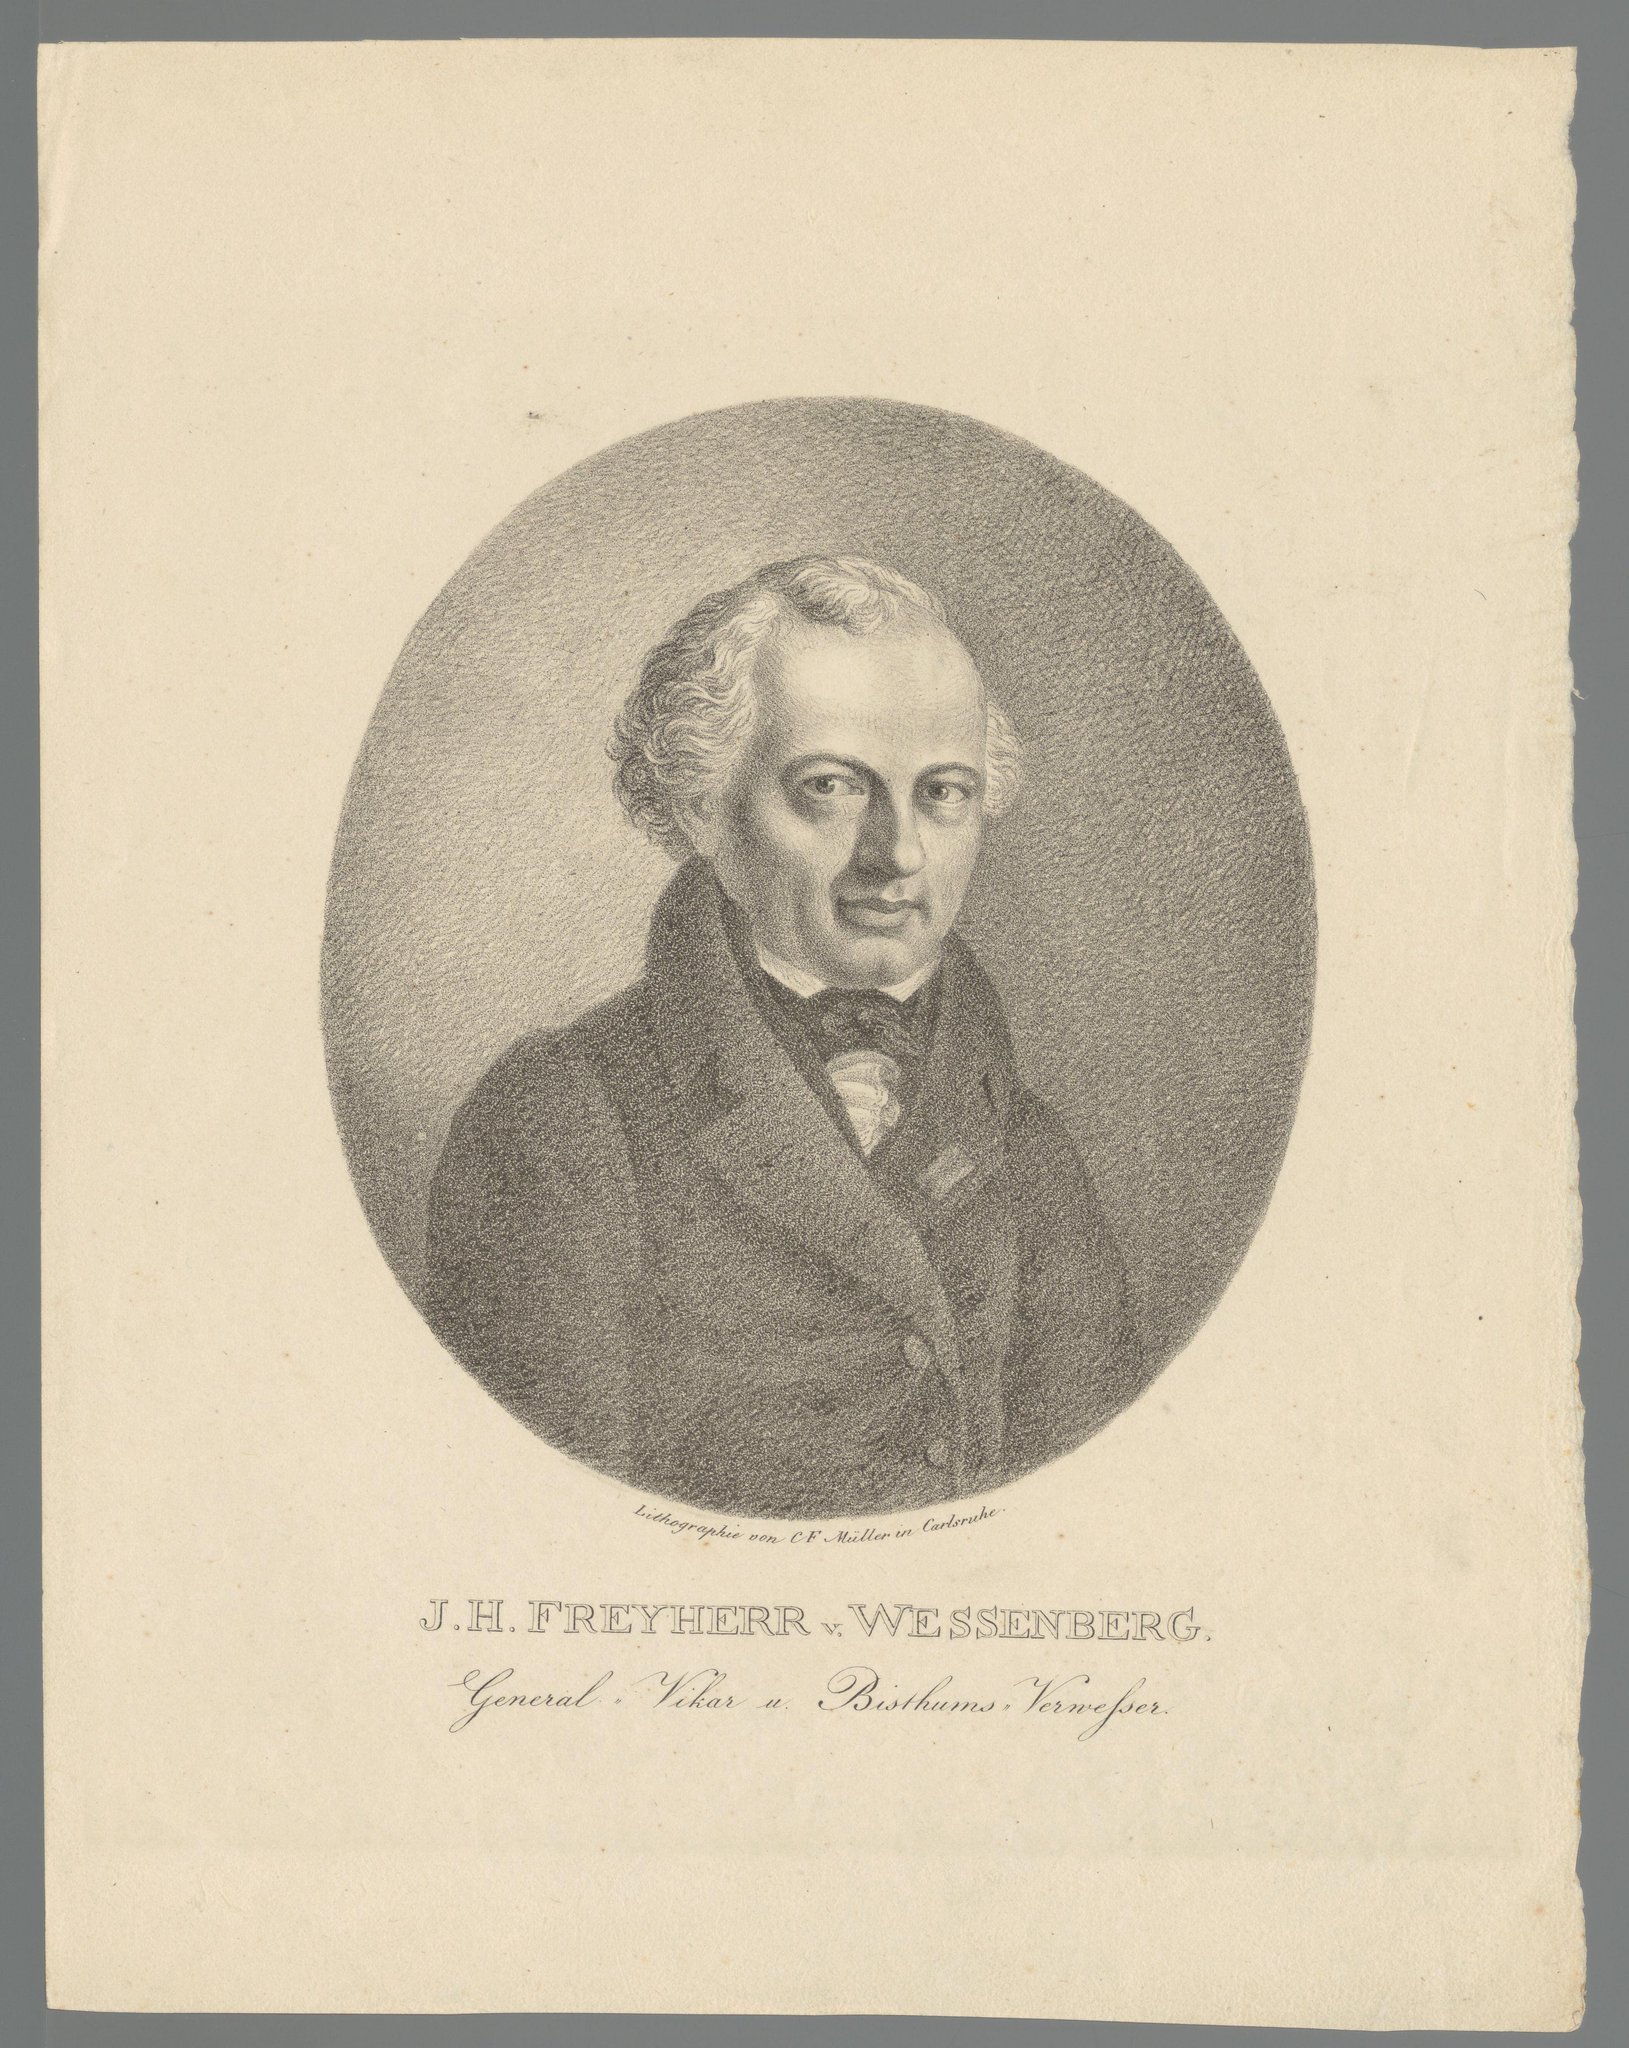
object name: print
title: J.H. Freyherr v. Wessenberg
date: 1820-1850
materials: paper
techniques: lithograph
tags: adult man, historical persons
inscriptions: collector's mark: Lugt 2228